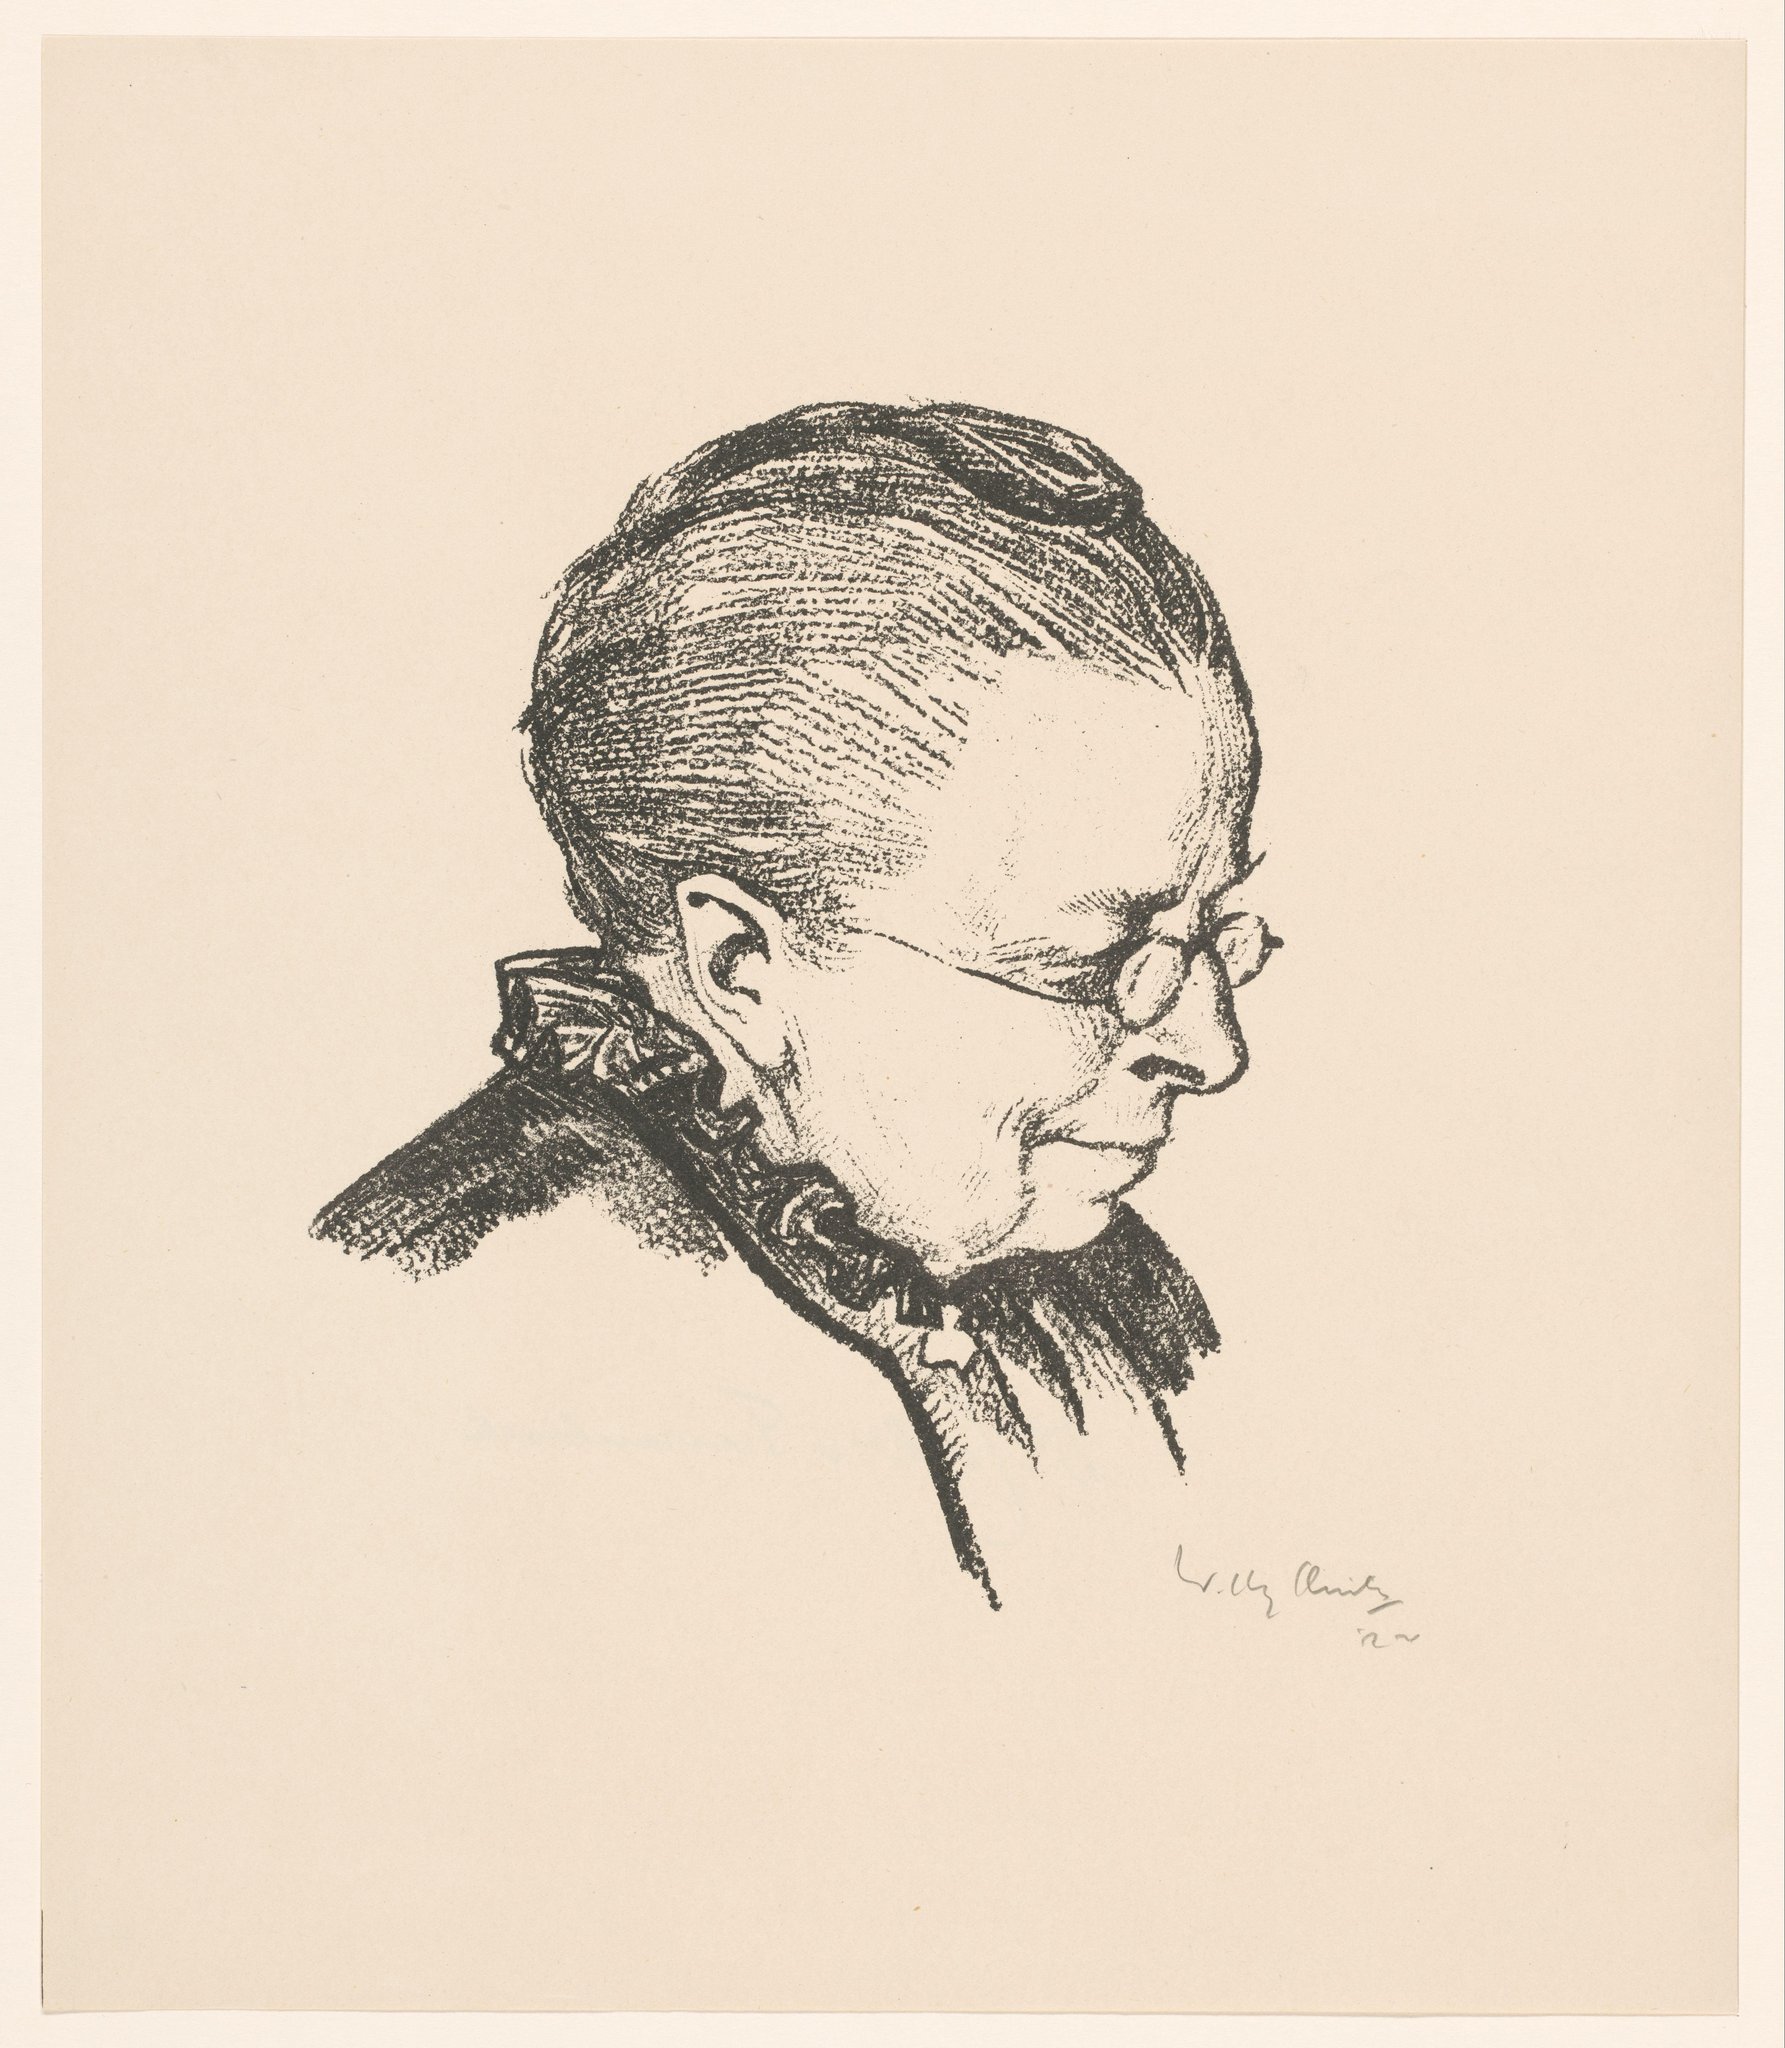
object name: print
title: Portret van Catharine van Tussenbroek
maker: willy sluiter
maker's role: draughtsman, painter, print maker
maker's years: 1873-1949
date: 1922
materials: paper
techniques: lithograph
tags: utrecht, amsterdam, historical persons - bb - woman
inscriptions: collector's mark: Lugt 2228